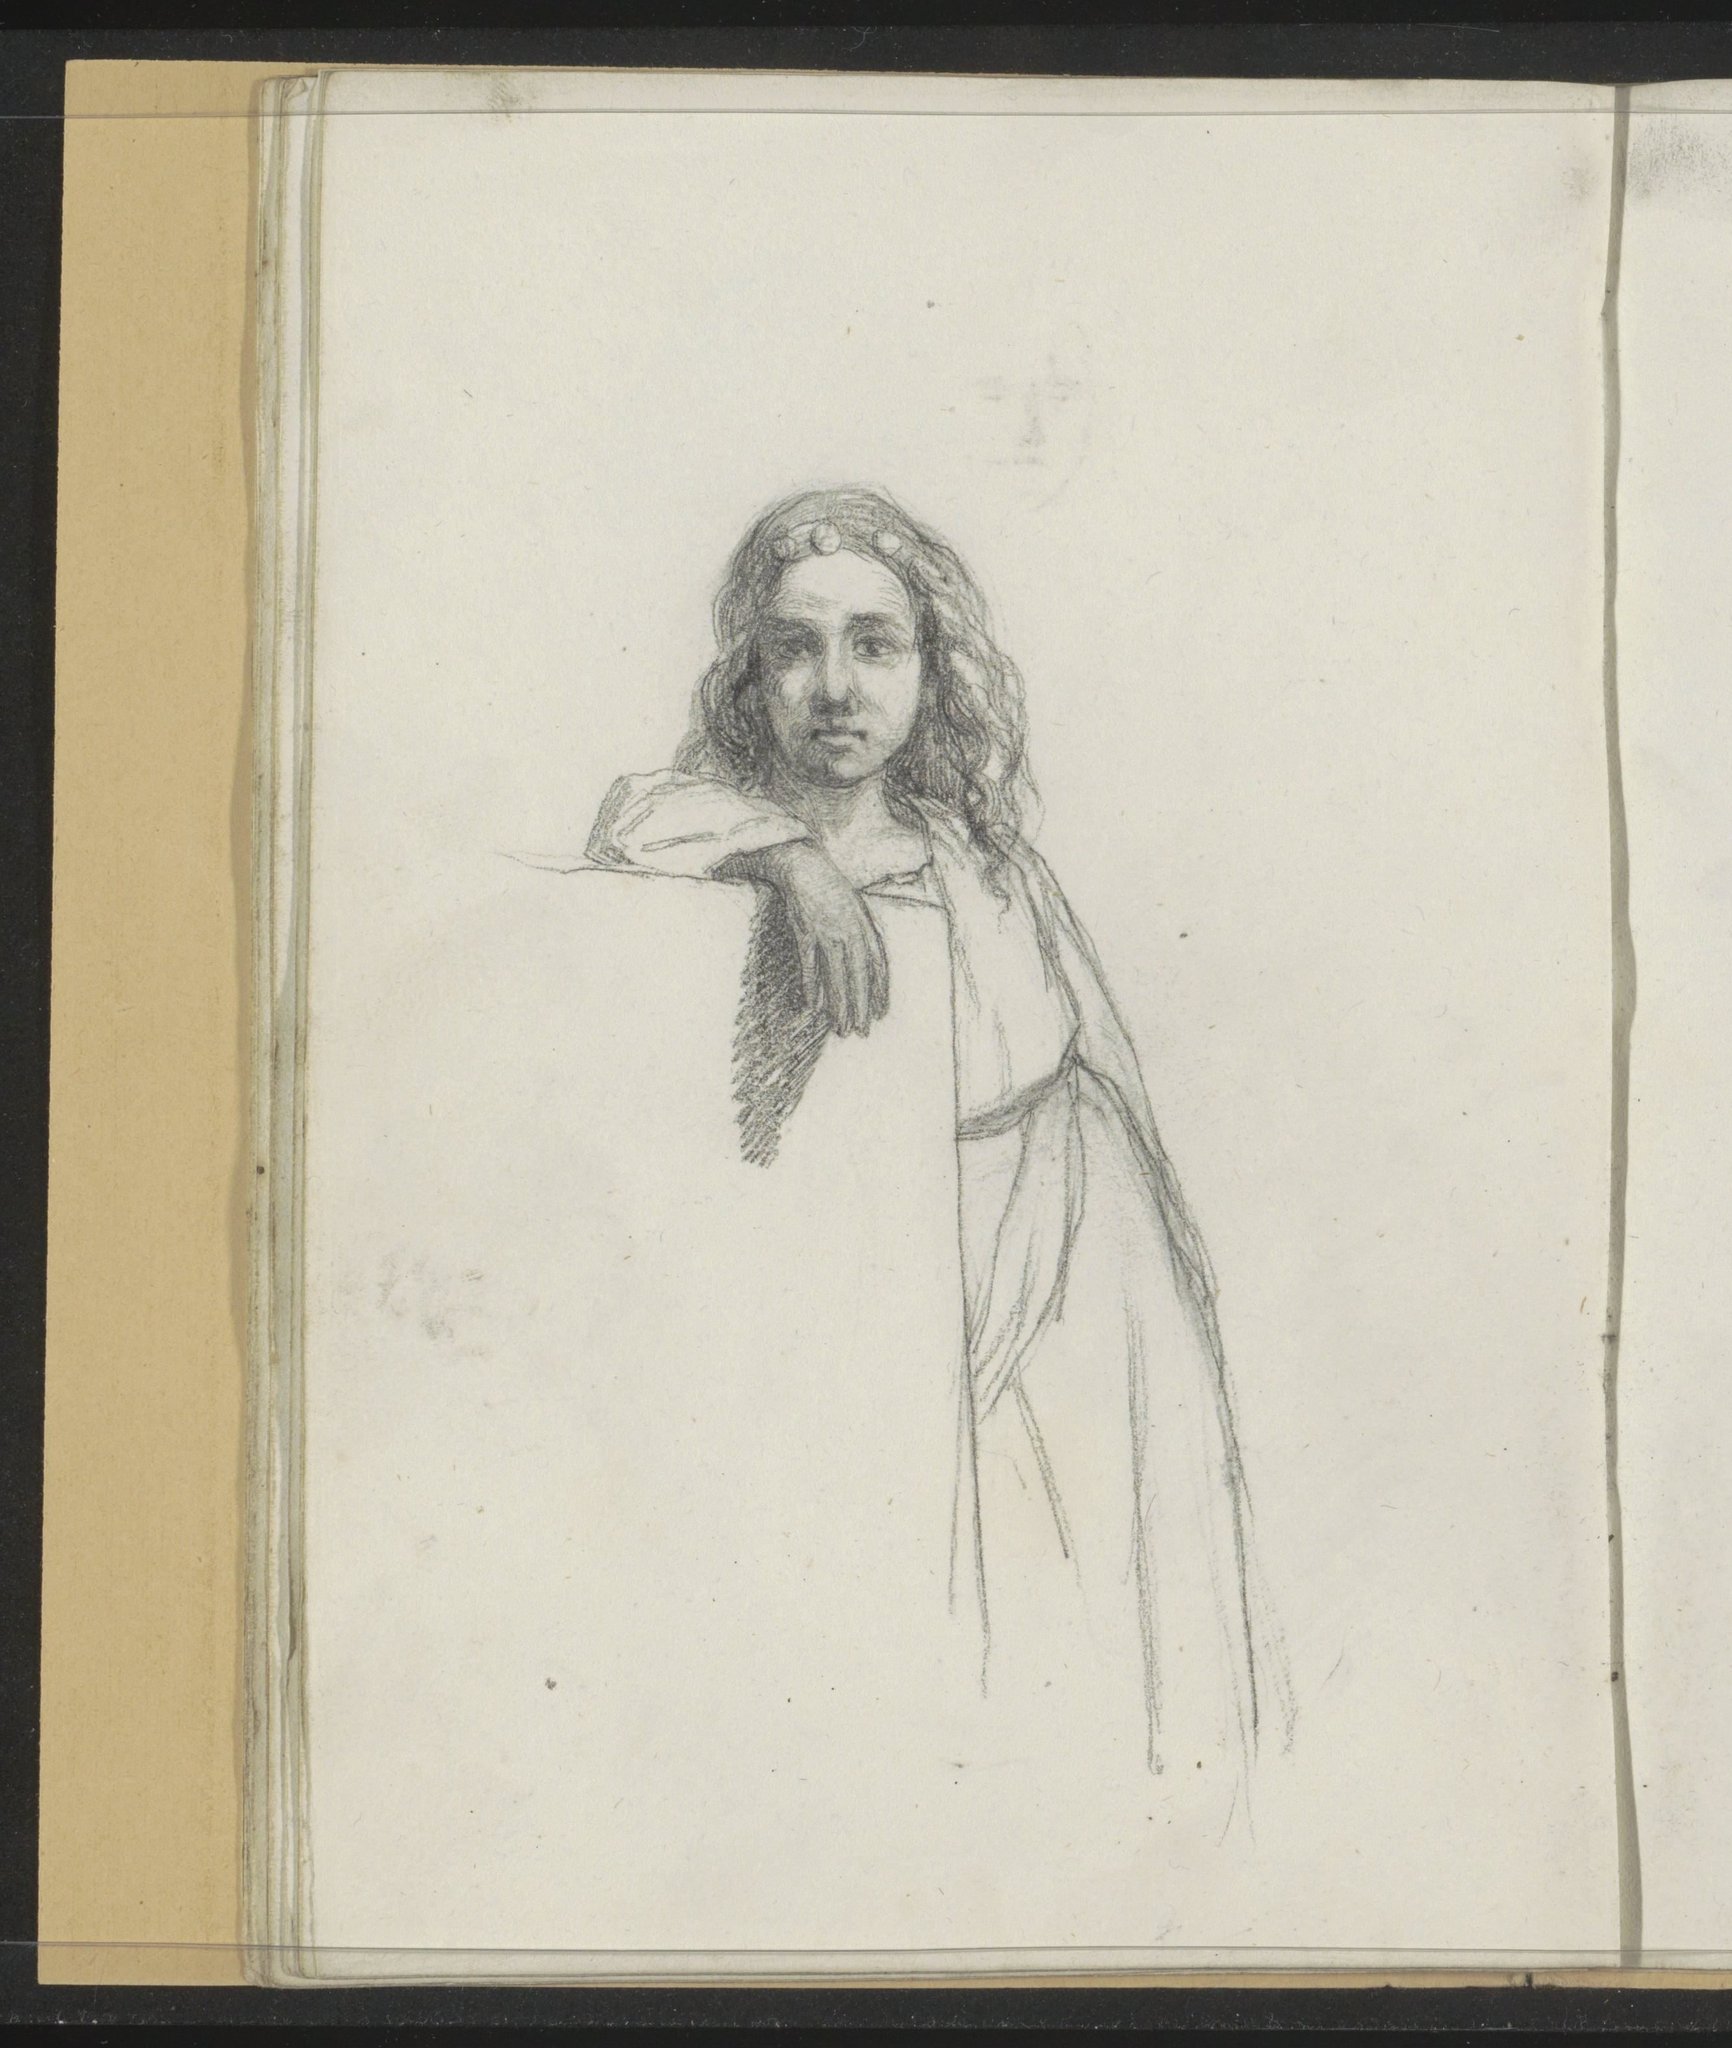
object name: sketchbook leaf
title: Staand meisje, met de linkerarm leunend op een muur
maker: jozef israëls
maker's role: draughtsman, painter, print maker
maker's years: 1824-1911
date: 1834-1911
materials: paper, pencil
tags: girl (child between toddler and youth), leaning figure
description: Het meisje draagt een diadeem of krans in haar lange haar. Blad 12 verso uit een schetsboek met 16 bladen.